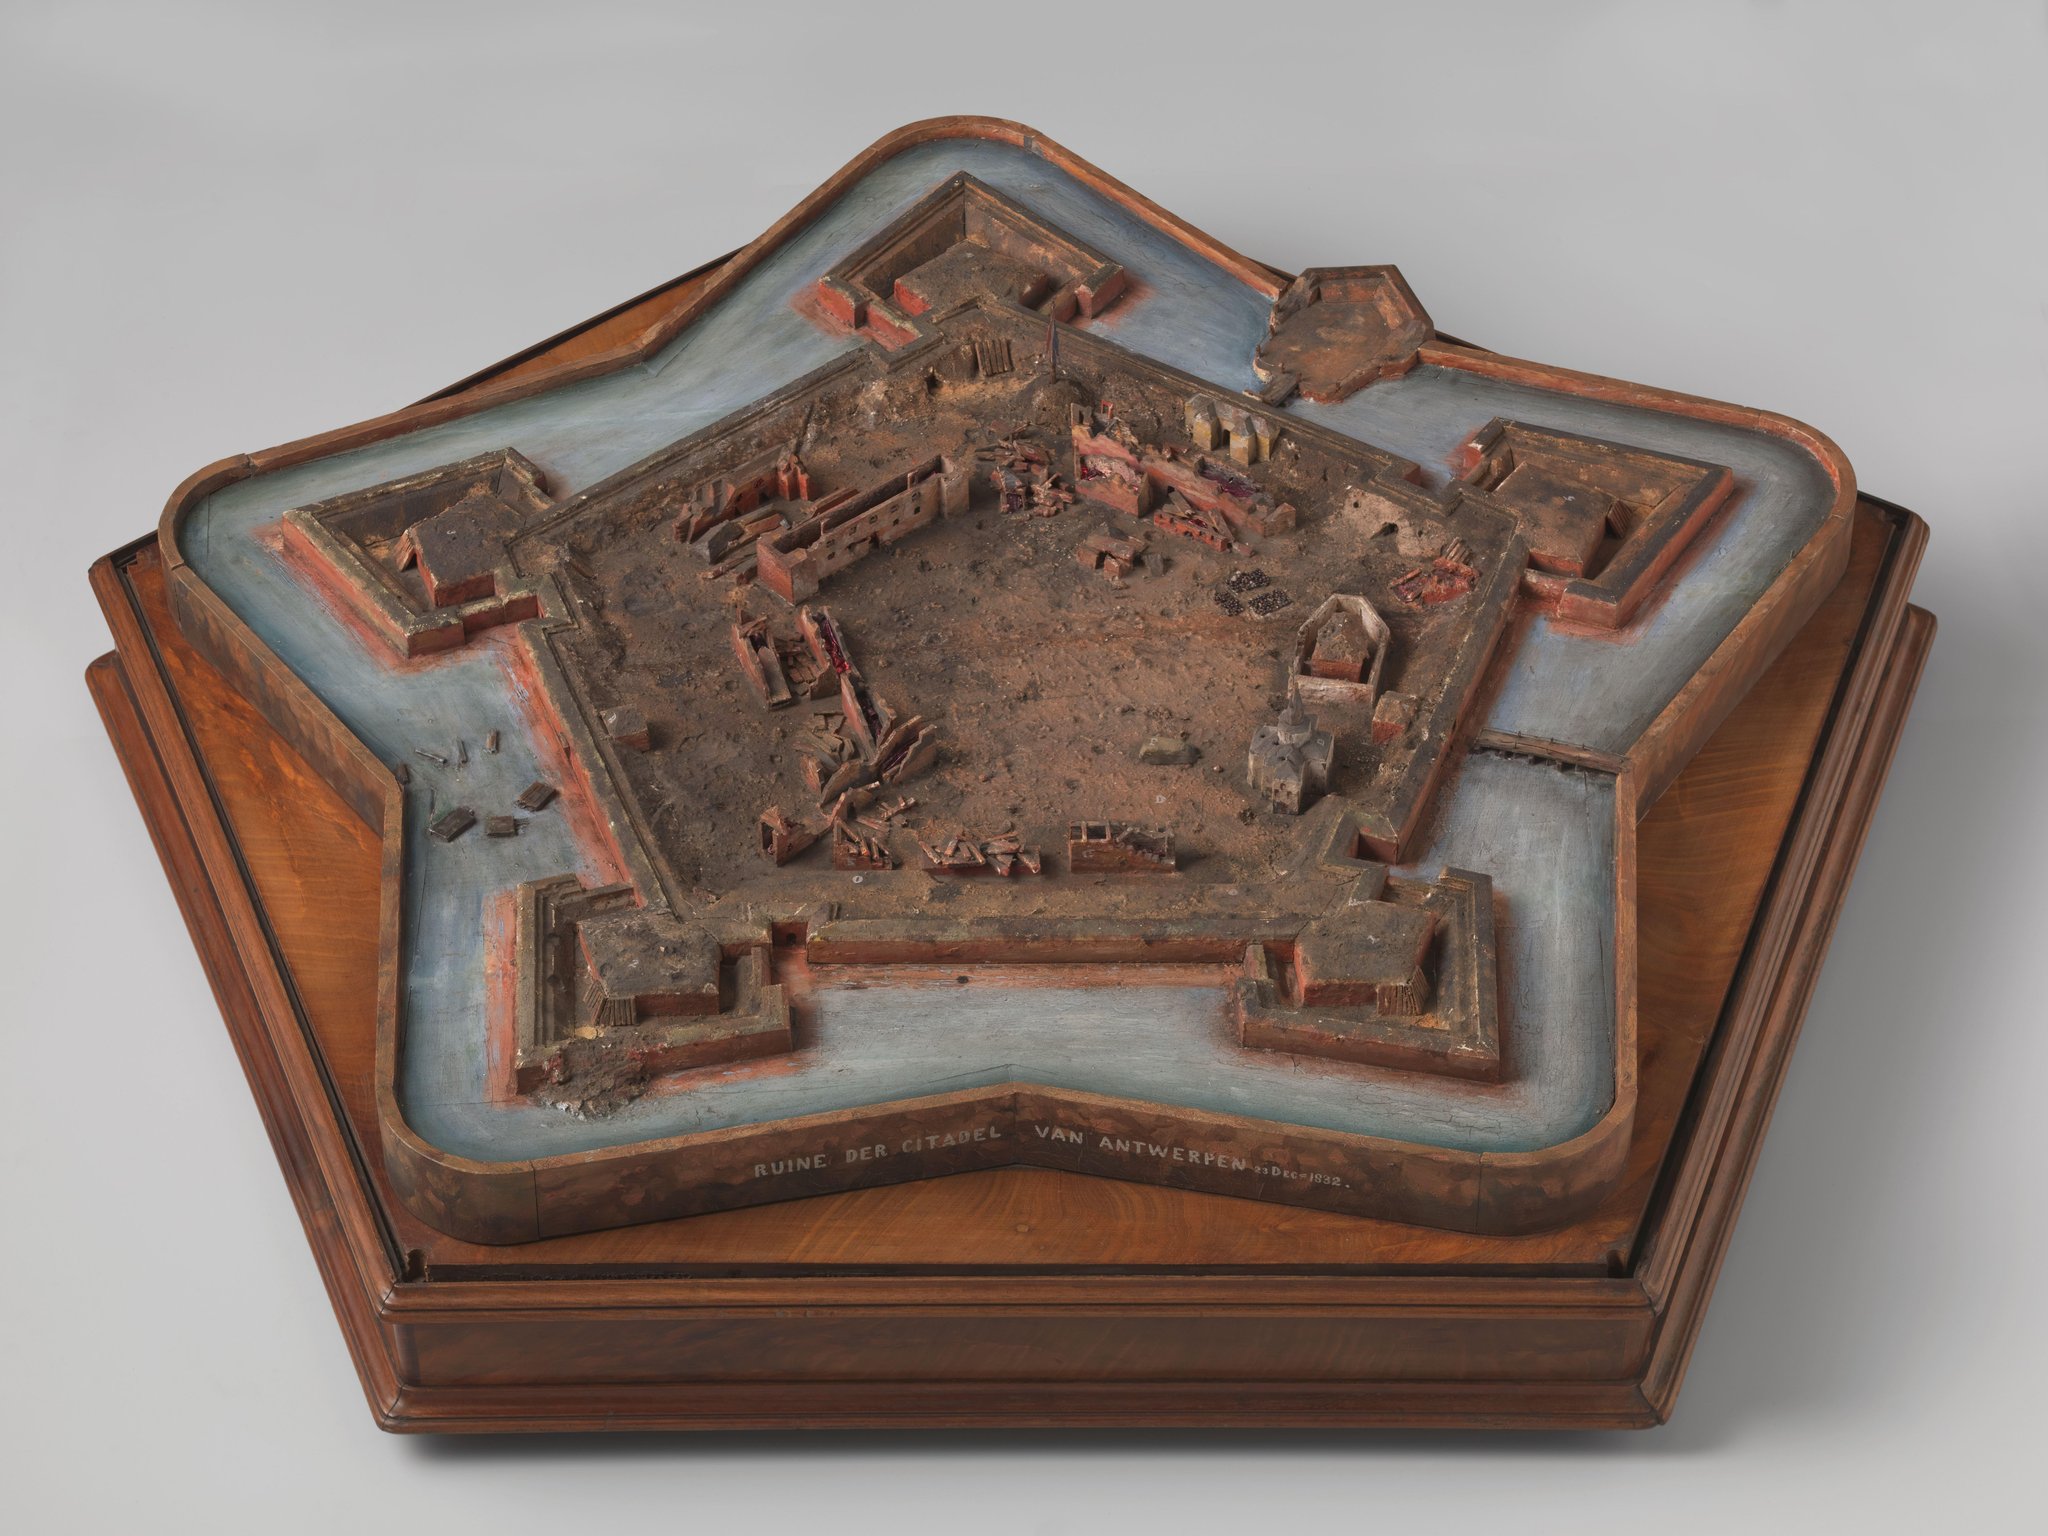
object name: maquette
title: Model van de ruïne van de citadel van Antwerpen vervaardigd onder toezicht van G. Vogel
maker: gilles vogel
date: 1875-1901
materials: plastic, wood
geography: netherlands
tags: gilles vogel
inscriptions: : ‘ruine der citadel van Antwerpen 23 dec= 1832’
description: Maquette van de citadel van Antwerpen in dec. 1832 op een 5-hoekig houten gelakt voetstuk met twee laden en op poten. Hierop hoorde een (verdwenen) glazen stolp. Op één zijde van het voetstuk staat in witte verf: 'ruine der citadel van Antwerpen 23 dec= 1832'. De maquette toont het 5-hoekige citadel met ruïnes van gebouwen. Dit is - van hout gemaakt en geverfd - behoorlijk beschadigd. Op de gebouwen staan letters, op de bastions cijfers verwijzend naar een legenda in een boekje NG-NM-11649-B (boekje is zoek).